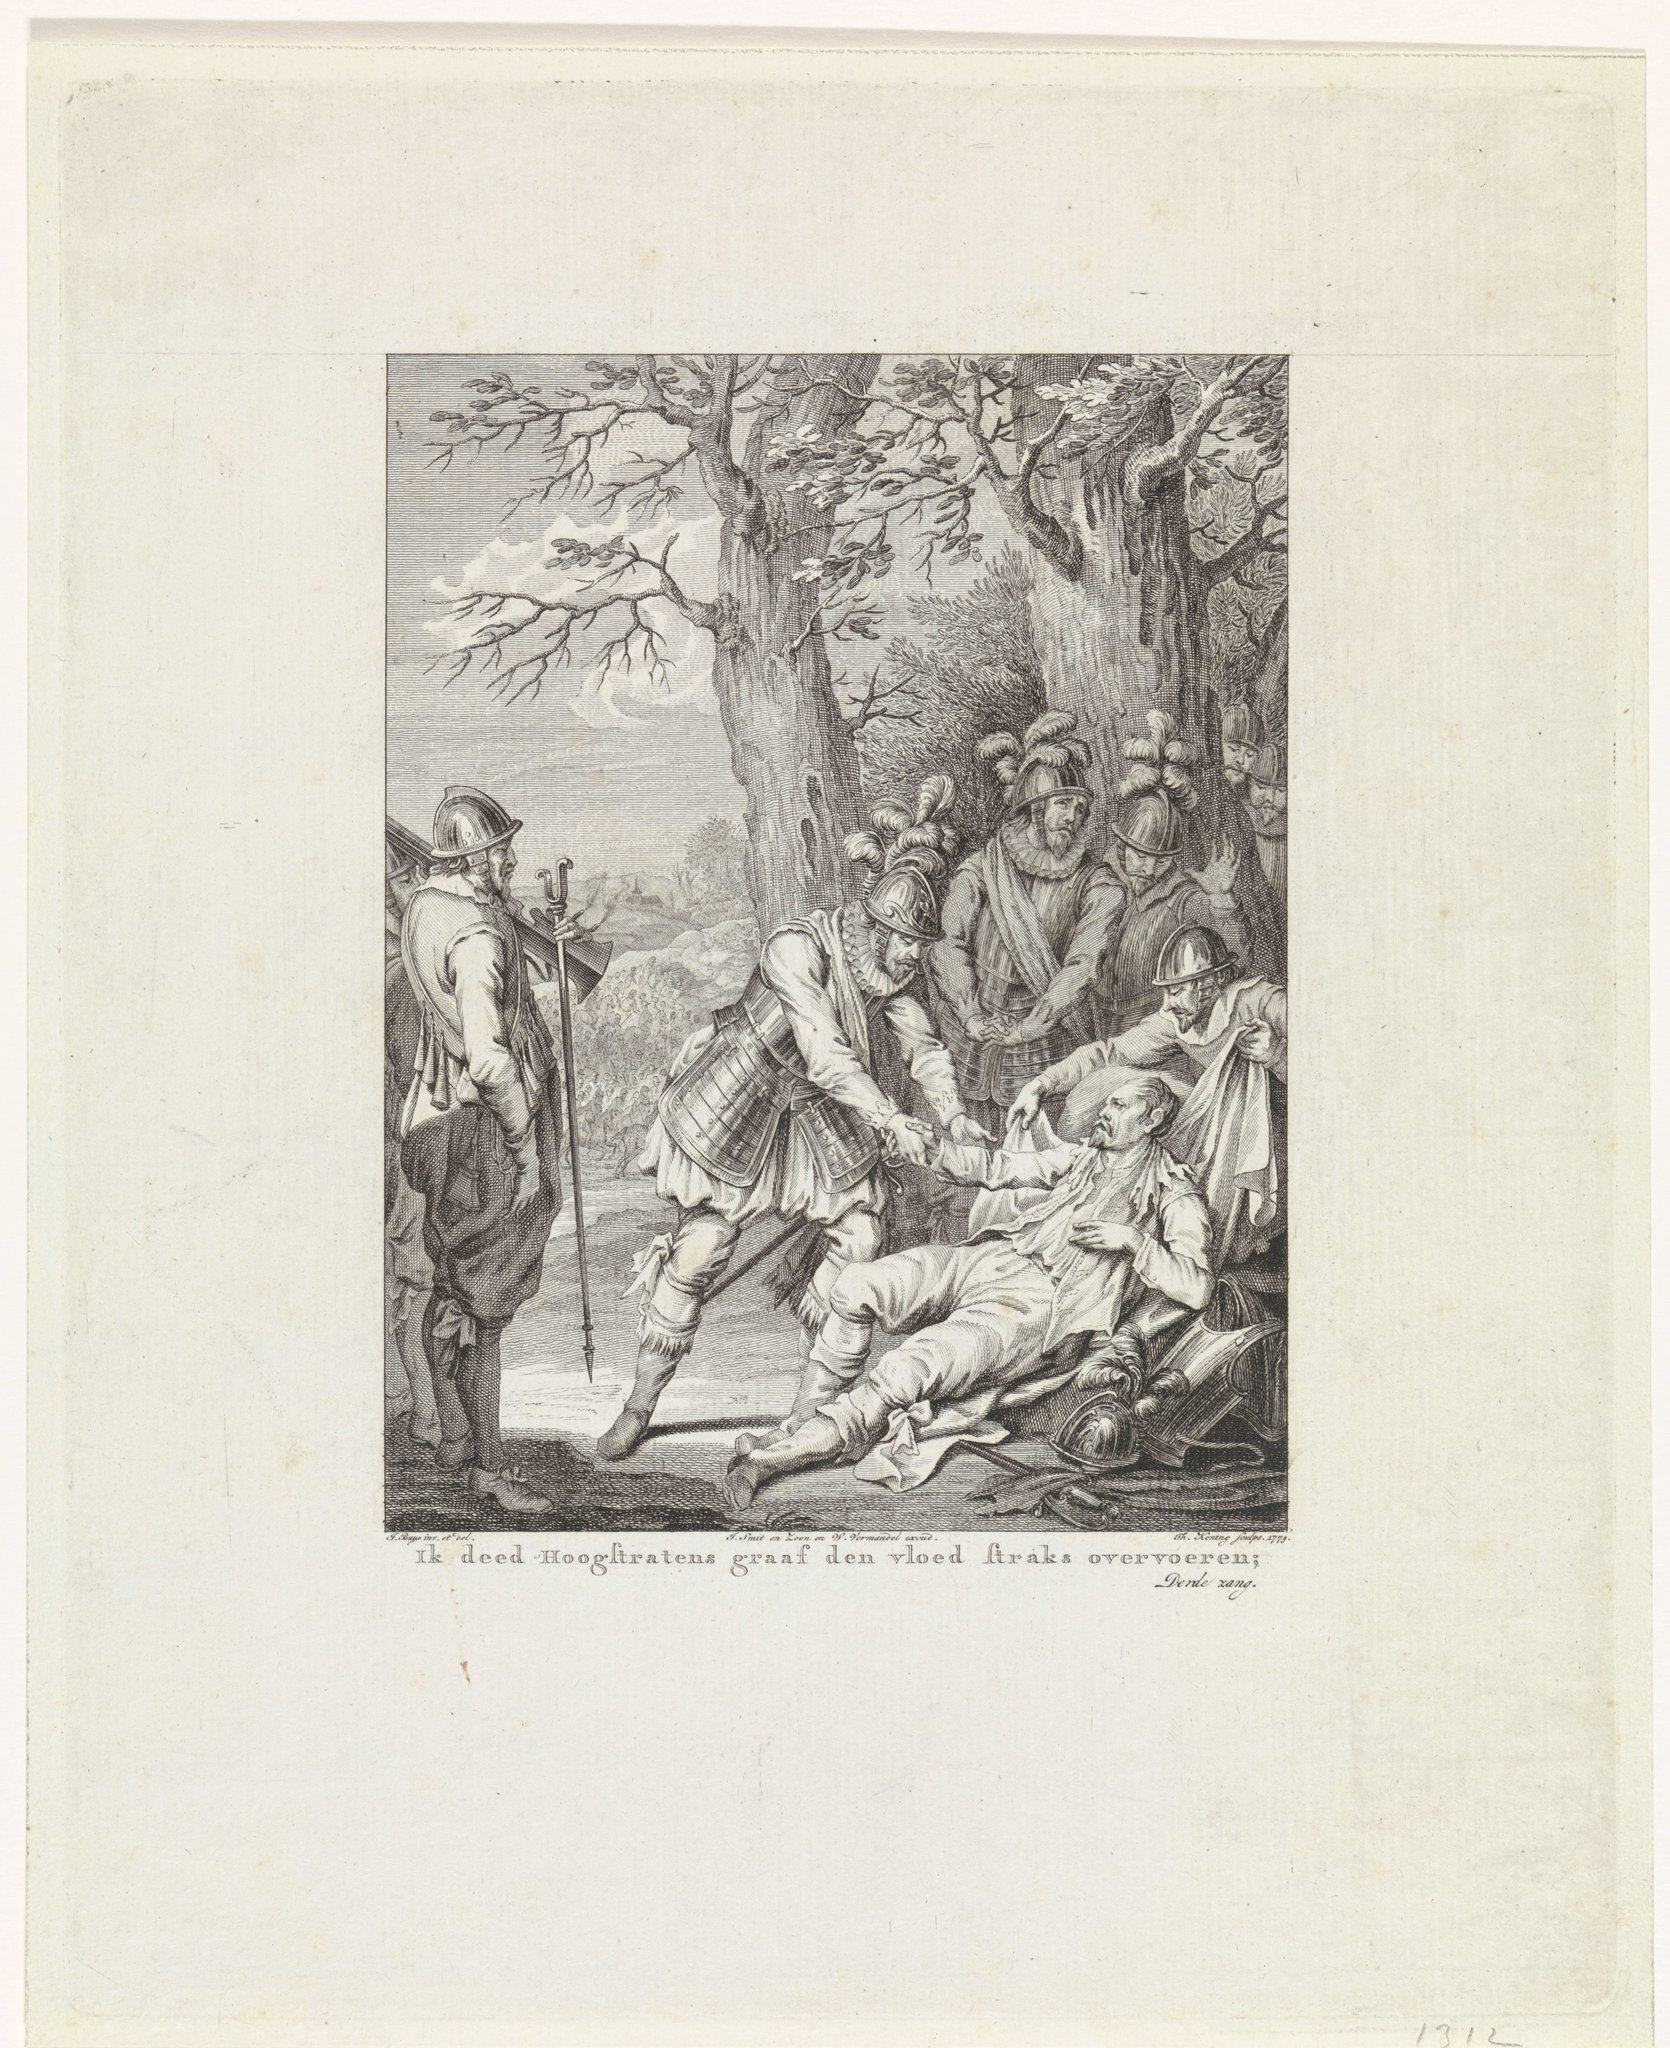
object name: print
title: Ik deed Hoogstratens graaf den vloed straks overvoeren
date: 1779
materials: paper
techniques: etching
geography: amsterdam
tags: william i (prince of orange), dying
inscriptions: collector's mark: Lugt 2228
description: Op 11 december 1568 sterft Anthony van Lalaing, graaf van Hoogstraten, te midden van soldaten, terwijl zijn hand door prins Willem I wordt vastgehouden. Deze prent maakt deel uit van een serie van 24 prenten met taferelen uit het leven van prins Willem I, 1568-1584 en is een illustratie bij de derde zang.